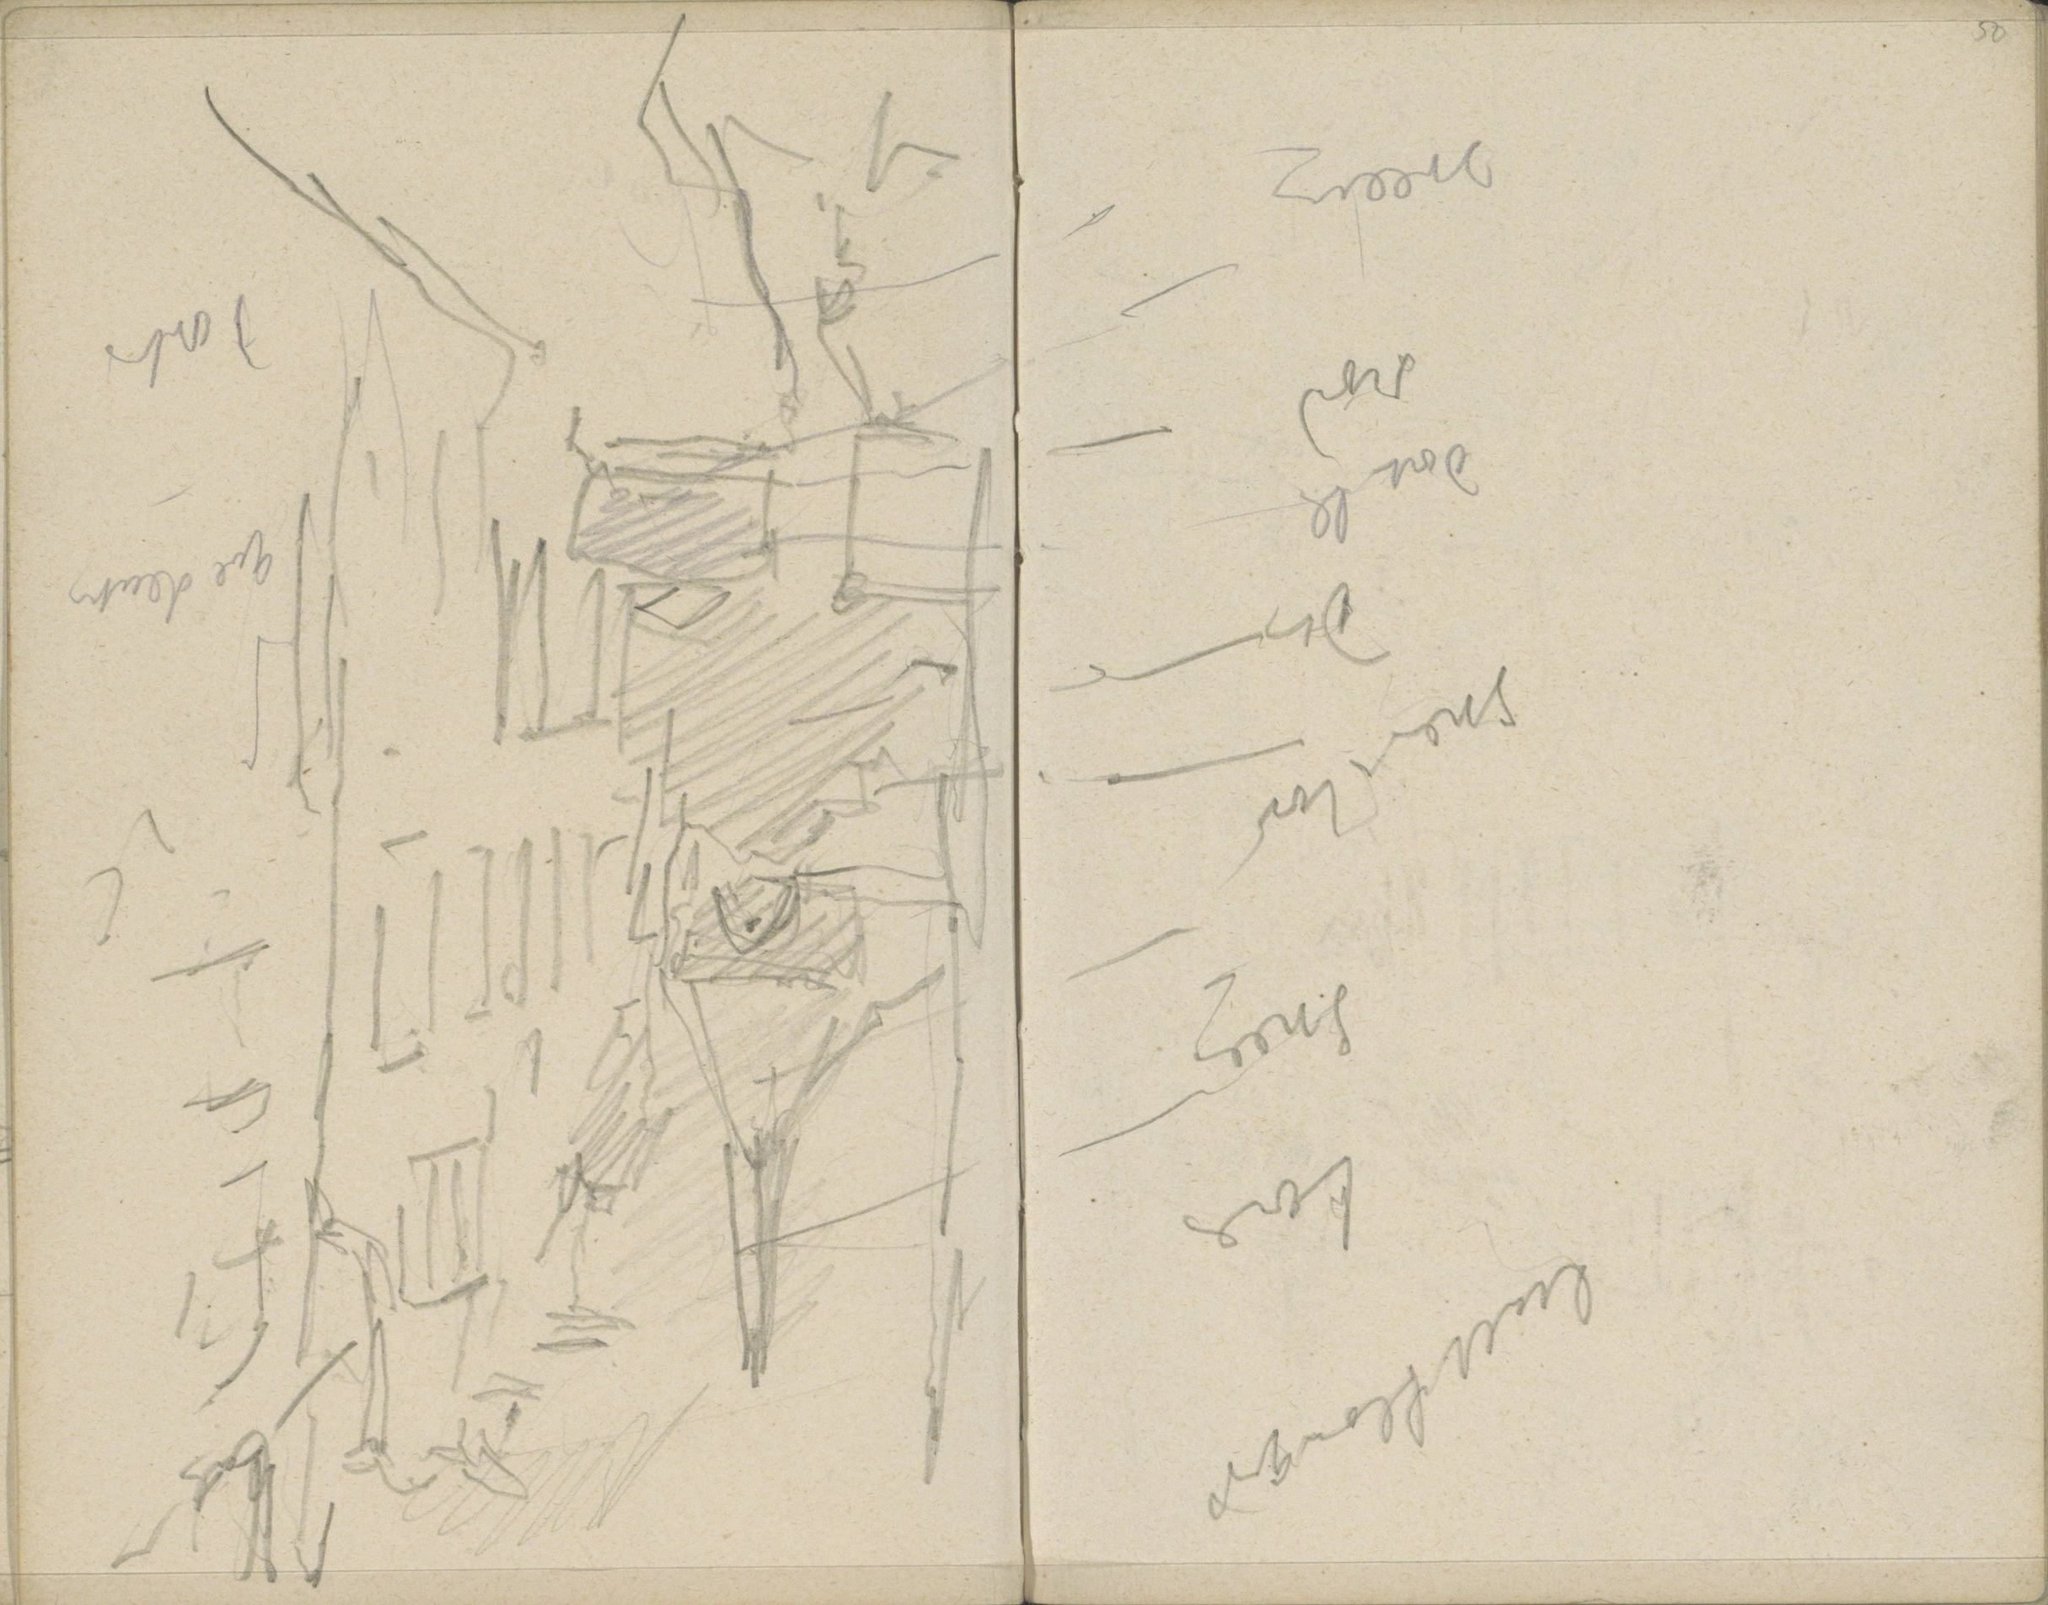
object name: sketchbook leaf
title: Gezicht op een straat in Amsterdam met een toren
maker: george hendrik breitner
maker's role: draughtsman, painter, print maker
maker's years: 1857-1923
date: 1914-1923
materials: paper, pencil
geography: amsterdam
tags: urban housing, church (exterior), street, amsterdam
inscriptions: kleurnotitie, handgeschreven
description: Gezicht op een straat in Amsterdam met een toren, mogelijk een kerktoren. Pagina 49 en pagina 50 uit een schetsboek met 43 bladen vervaardigd te Amsterdam.